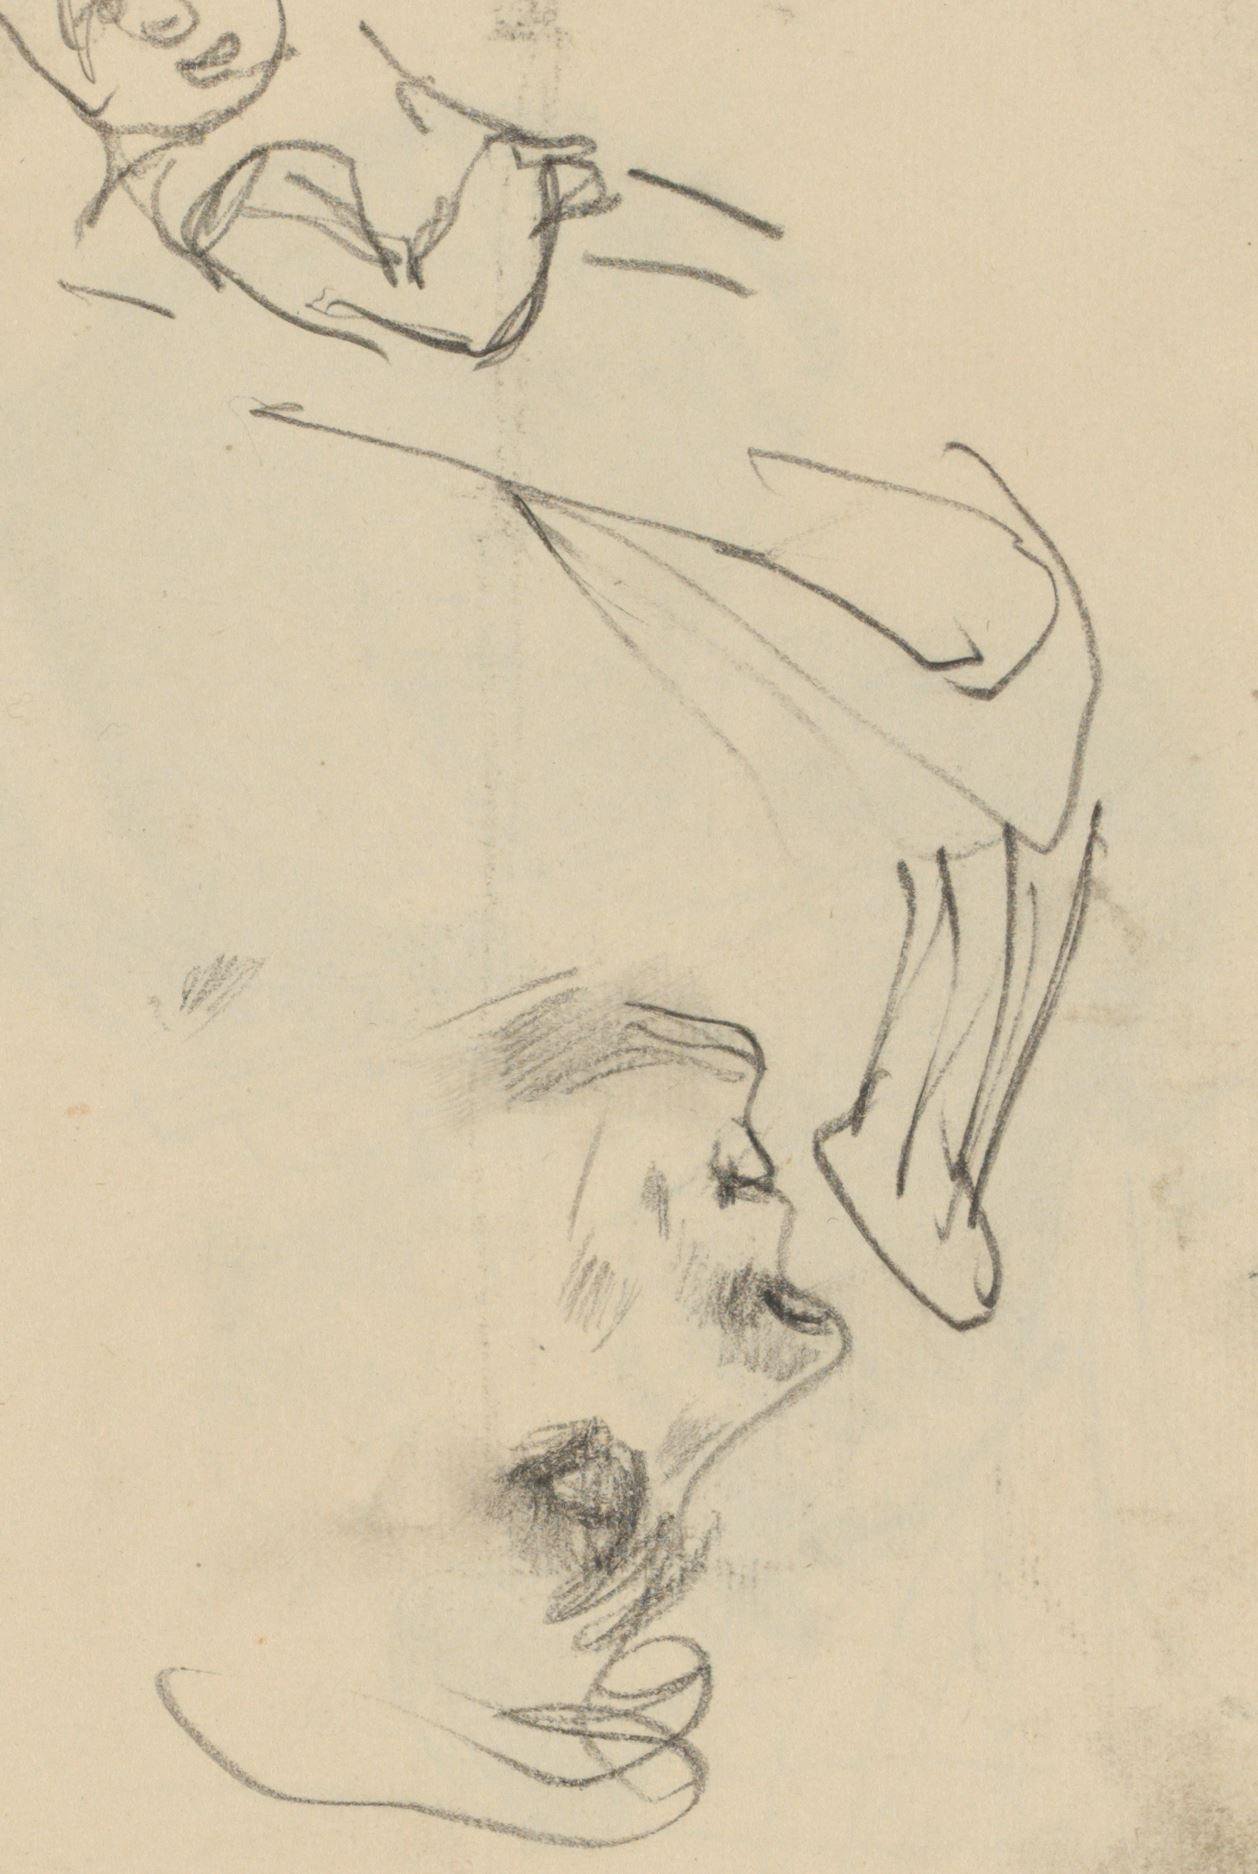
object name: sketchbook leaf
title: Kind en een mannenhoofd in profiel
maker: george hendrik breitner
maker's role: draughtsman, painter, print maker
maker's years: 1857-1923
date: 1880-1882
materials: chalk, paper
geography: the hague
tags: head (human) (+ sideview, profile), child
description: Pagina 10 uit een schetsboek met 19 bladen.